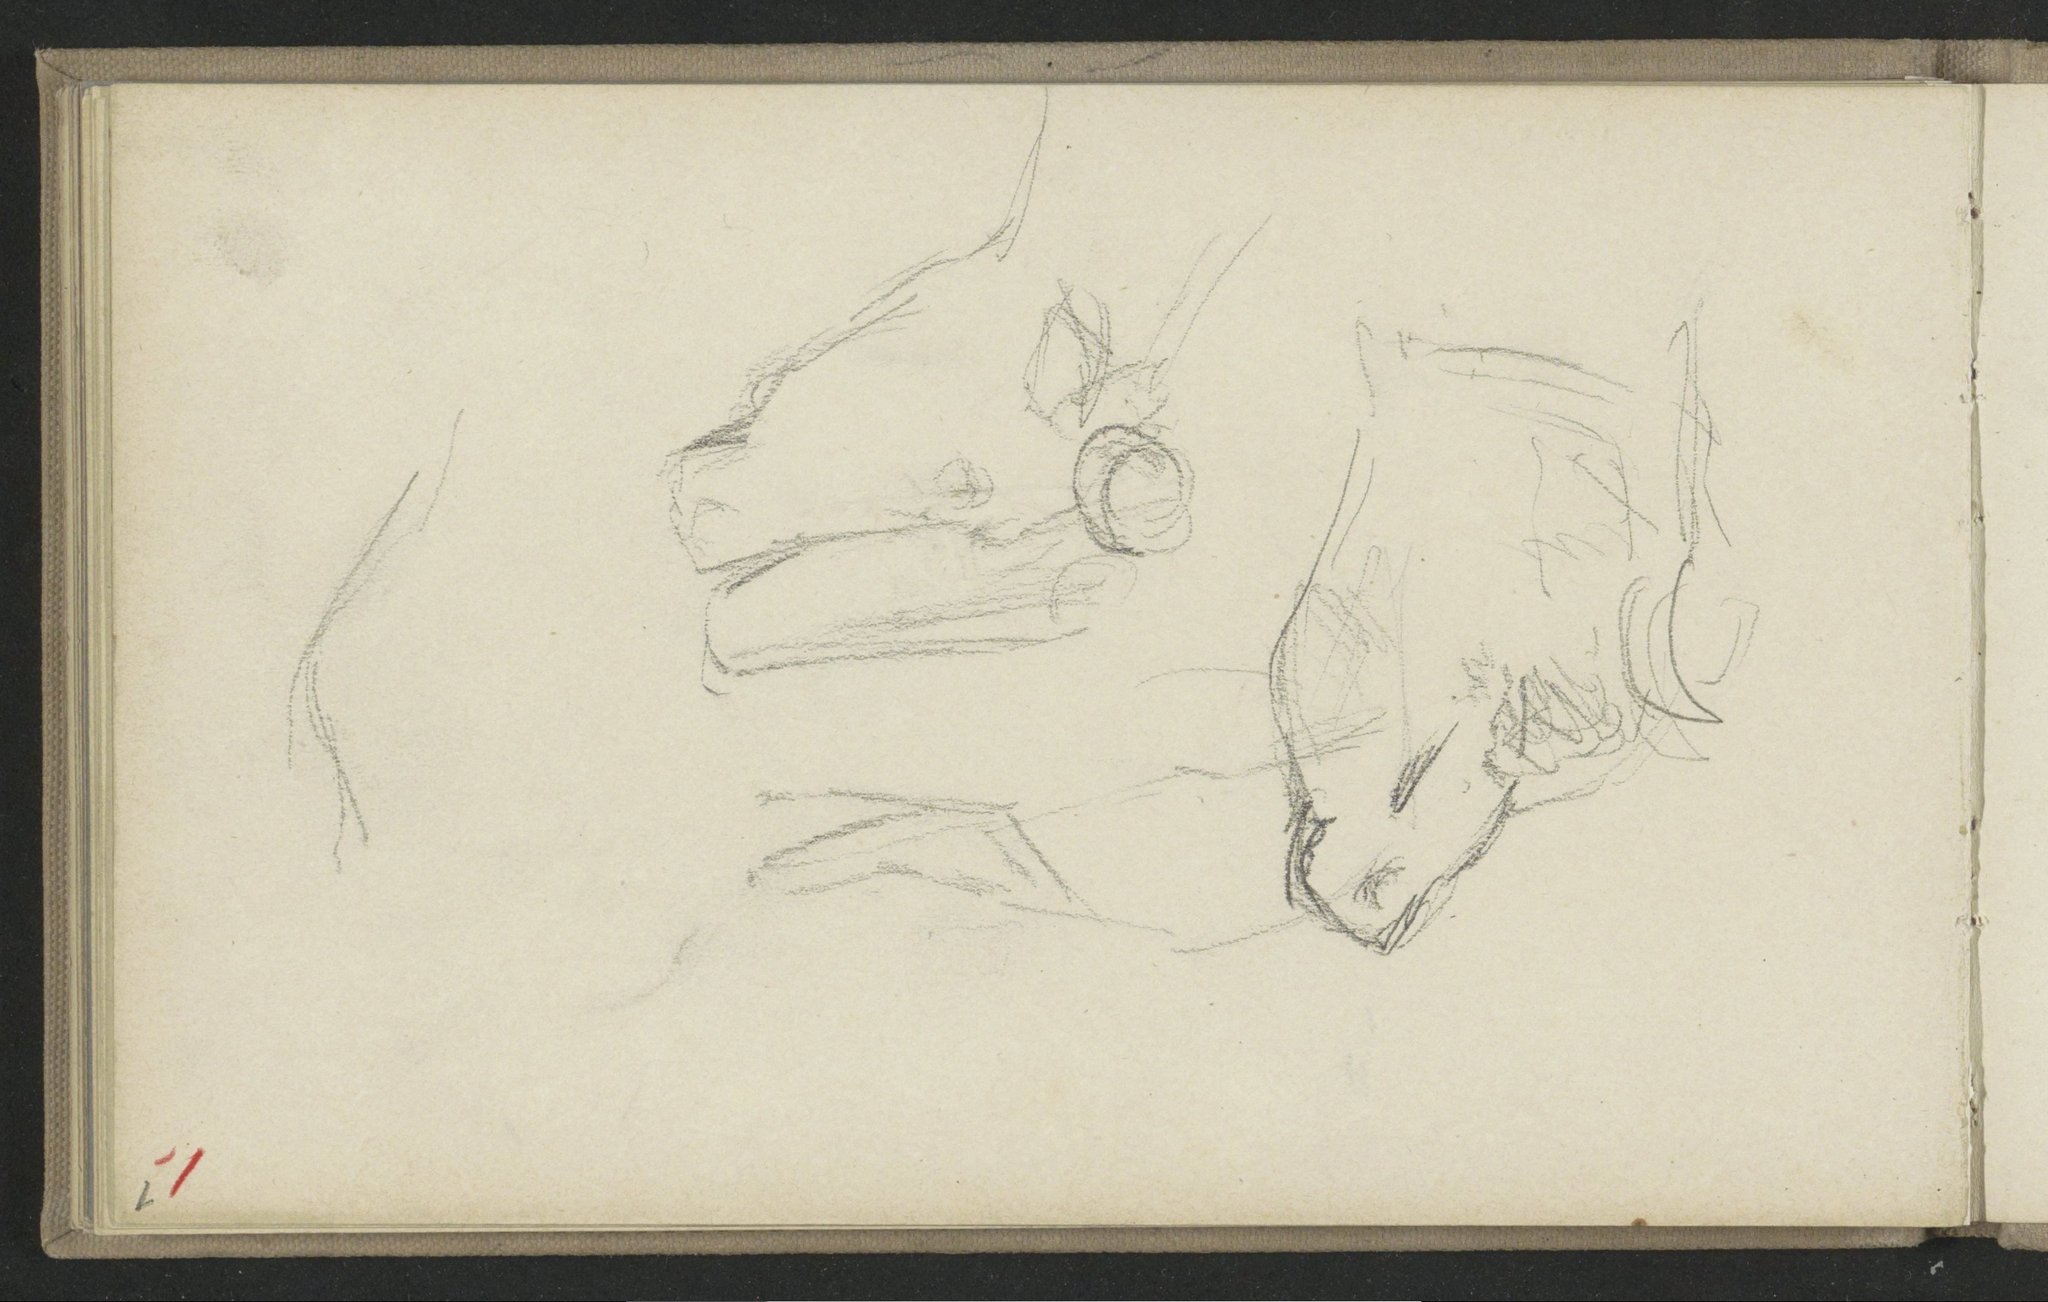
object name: sketchbook leaf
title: Kop van een koe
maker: jozef israëls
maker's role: draughtsman, painter, print maker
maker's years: 1824-1911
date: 1834-1911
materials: paper, pencil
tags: cow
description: Blad 26 verso uit een schetsboek met 26 bladen.